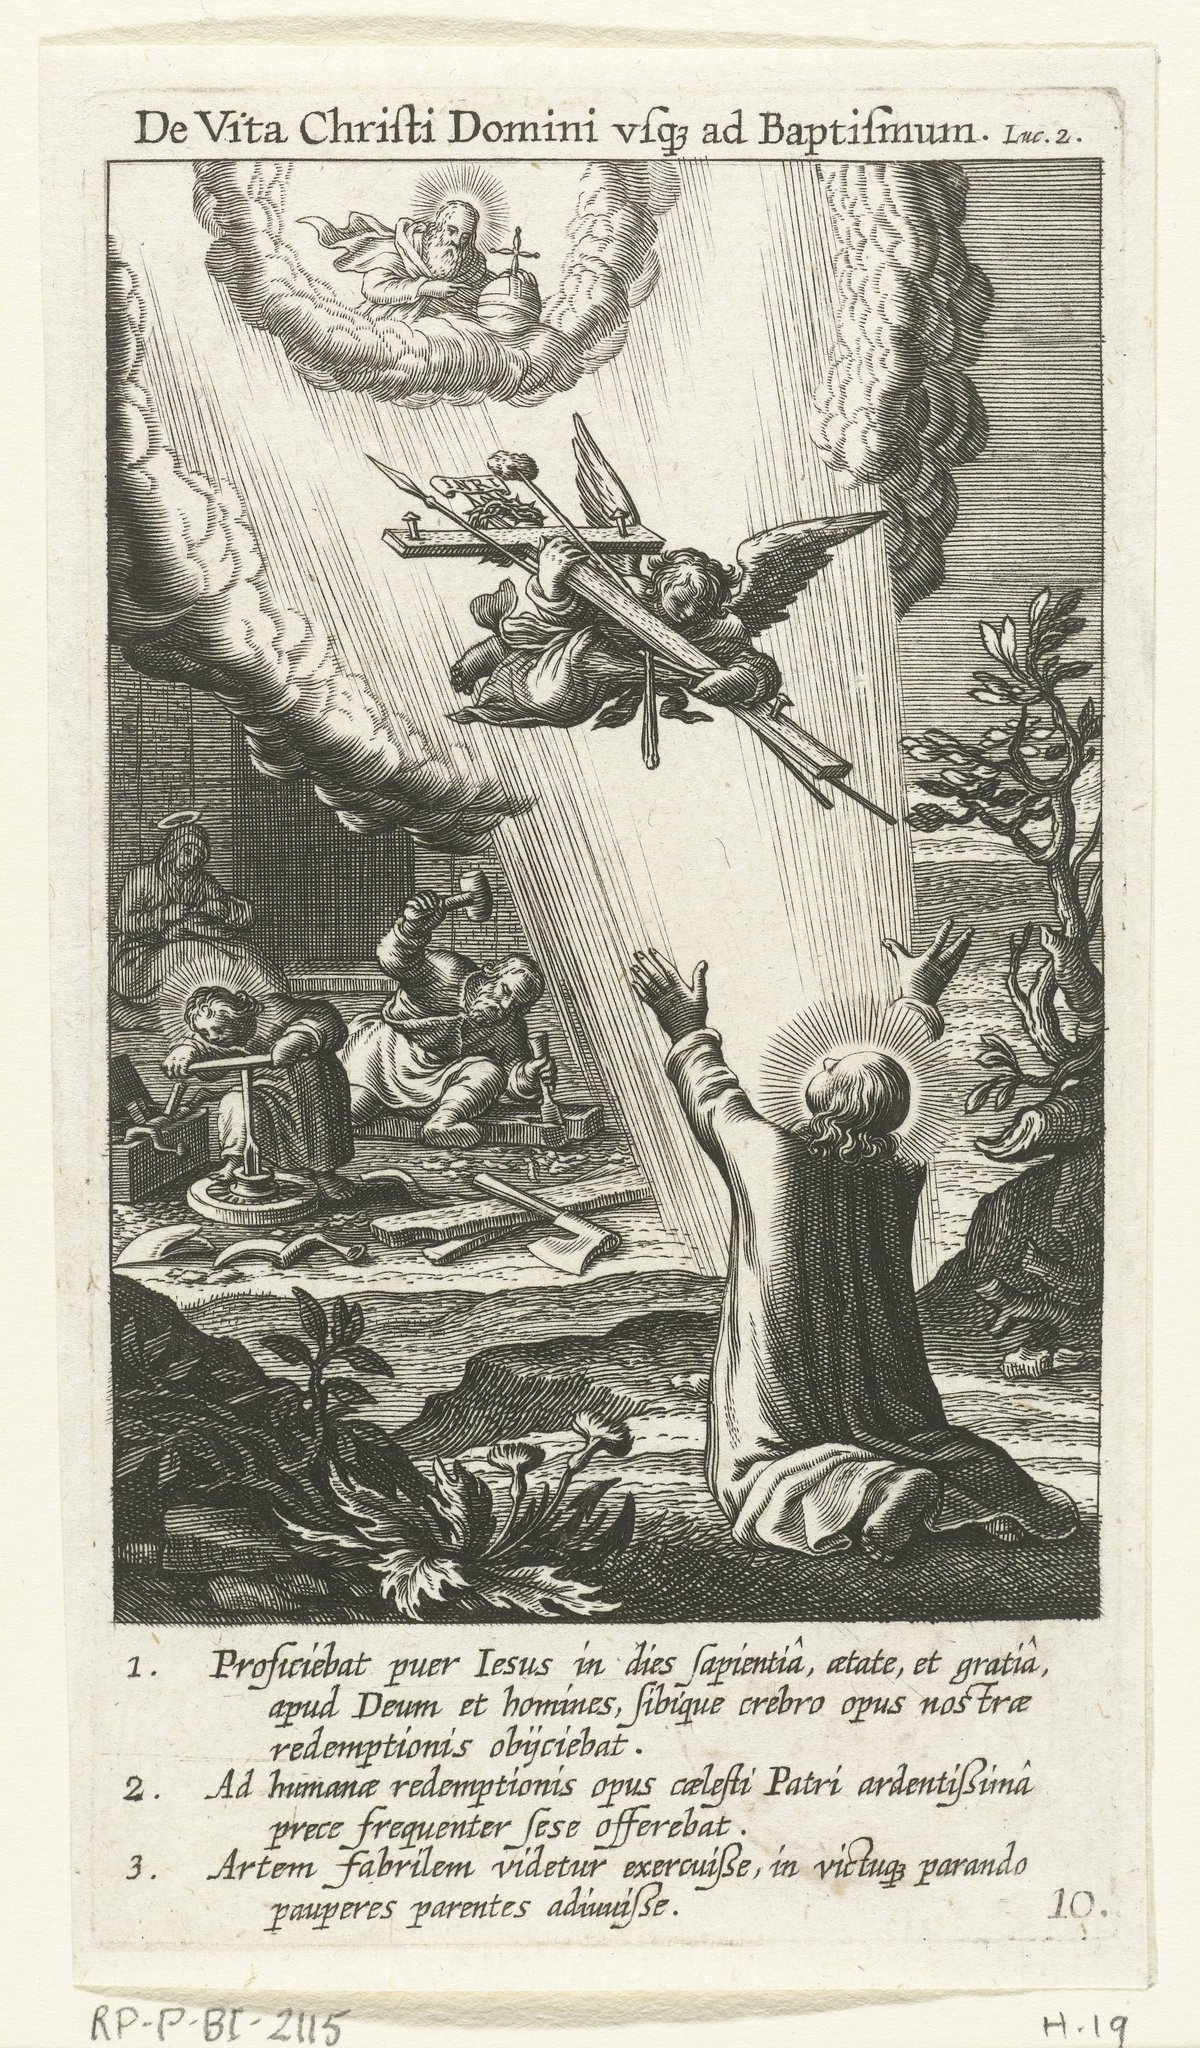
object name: book illustration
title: Vitae passionis et mortis Jesu Christ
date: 1590-1622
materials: paper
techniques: engraving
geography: antwerp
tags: 'arma christi', joseph with the christ-child (and mary) in his carpenter's workshop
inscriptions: collector's mark: Lugt 240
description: Jonge Christus knielt met Heilige Geest boven zijn hoofd en ontvangt passiewerktuigen van engel. In de hemel verschijnt God de Vader. Op de achtergrond Christus als kind werkend met Jozef in zijn werkplaats. In bovenmarge regel Latijn uit Lucas 2.